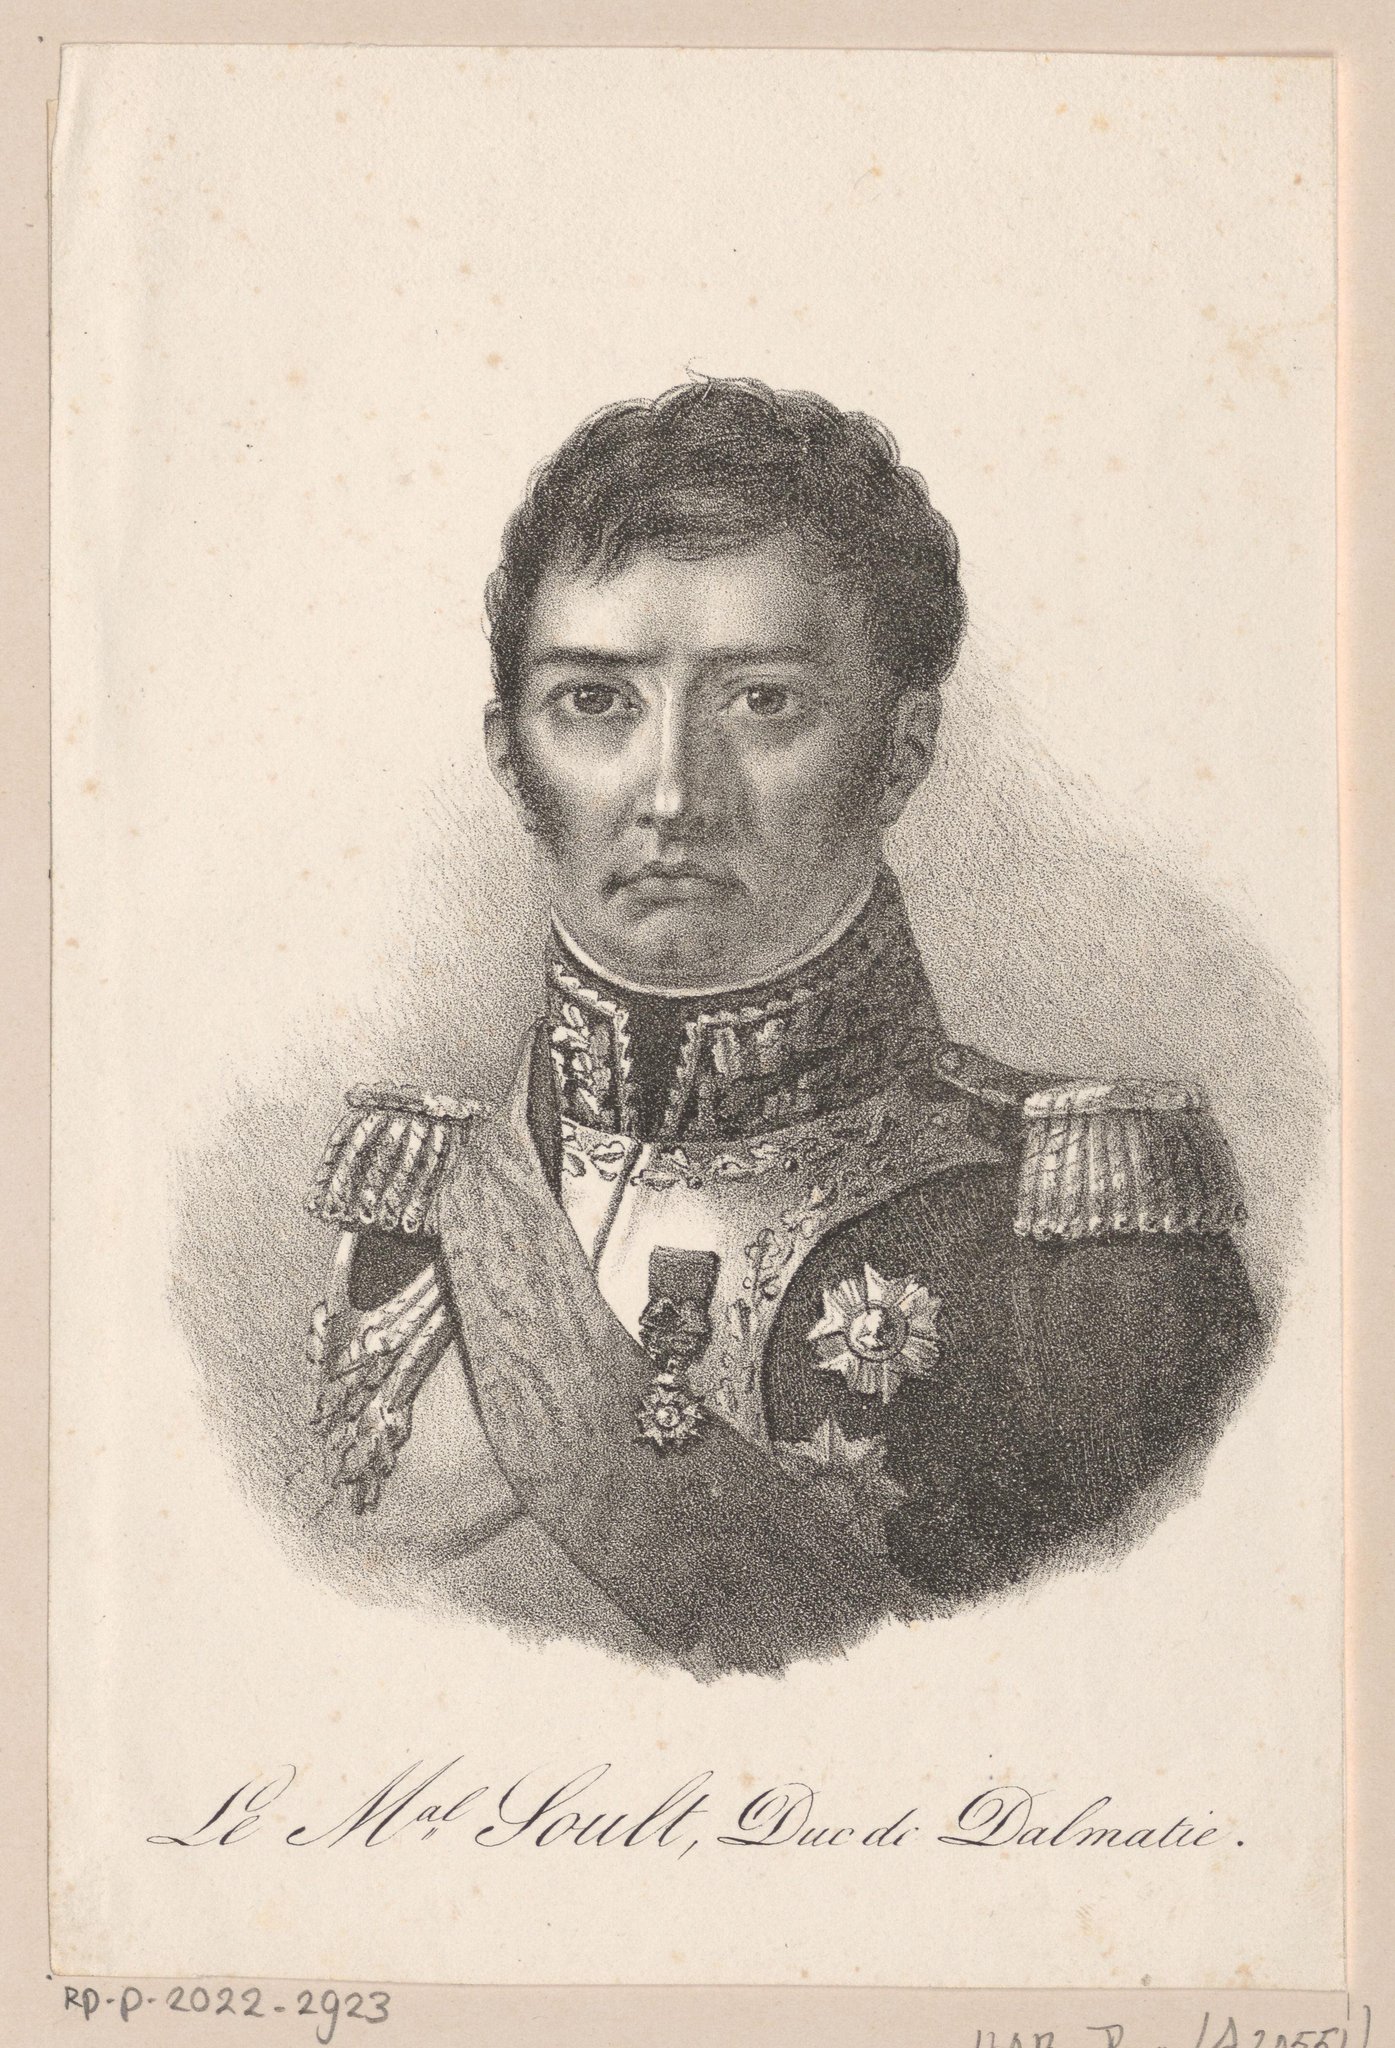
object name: print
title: Portret van Nicolas Jean-de-Dieu Soult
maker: Anonymous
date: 1804-1899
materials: paper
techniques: lithograph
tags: commander-in-chief, general, marshal, historical persons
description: Met eenregelig onderschrift in het Frans.